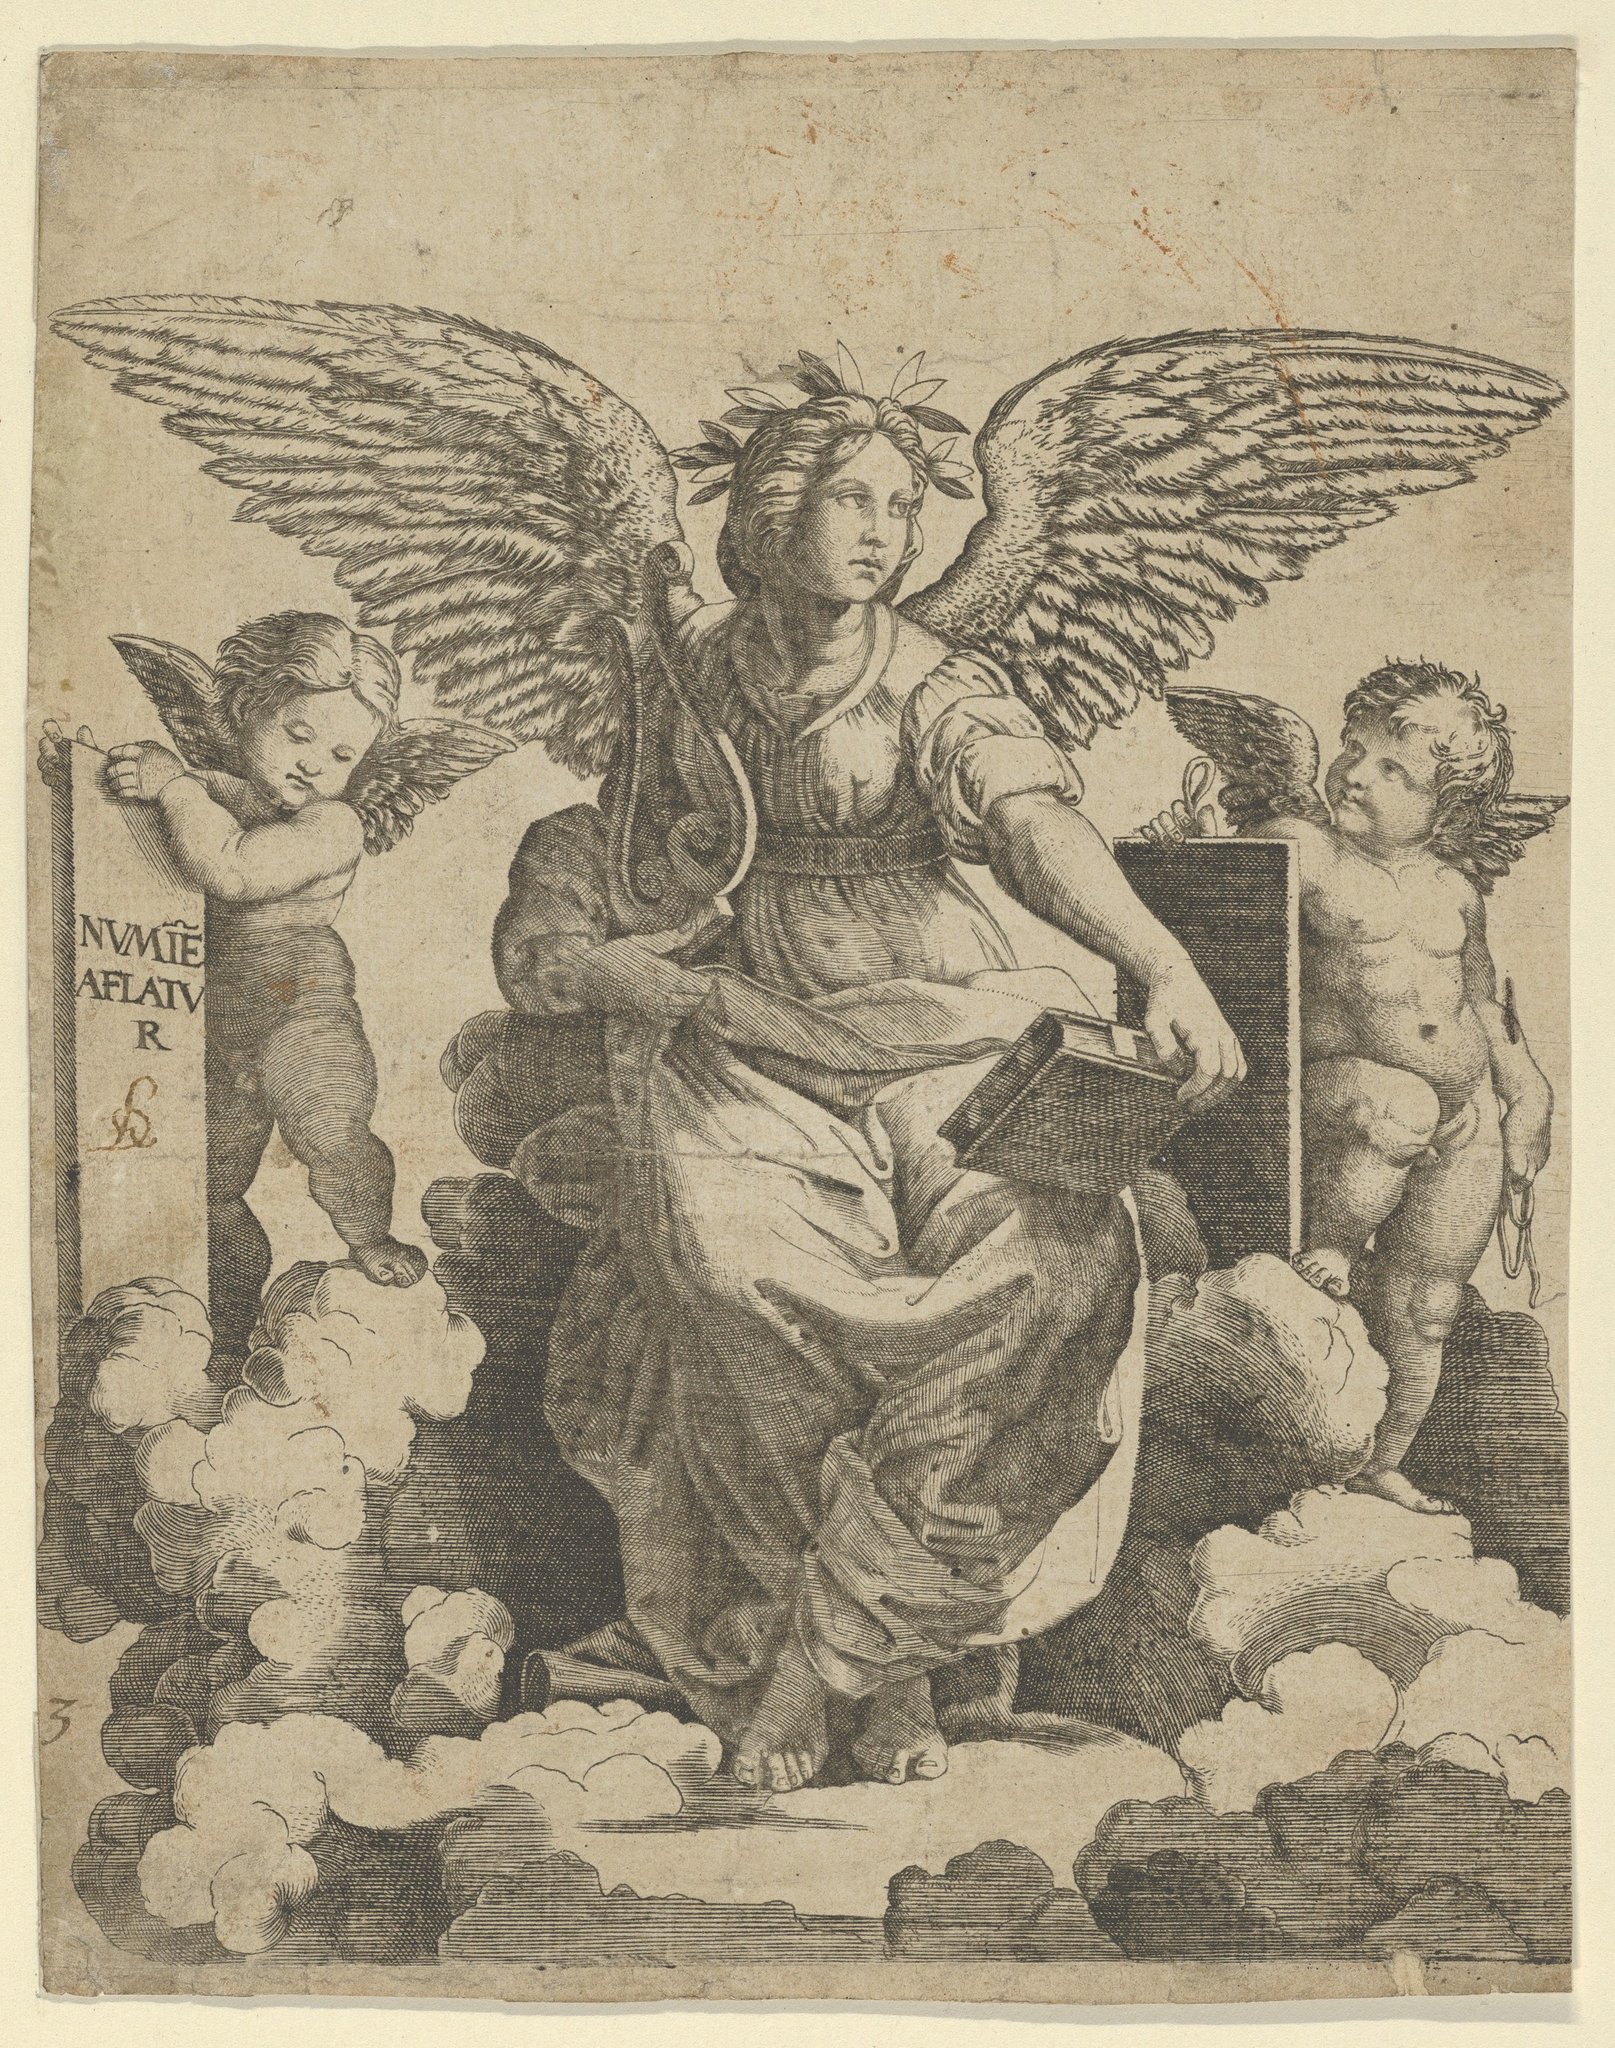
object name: print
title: Poetry personified as a winged woman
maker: Anonymous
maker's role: artist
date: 1515-1550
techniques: engraving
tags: women,putti